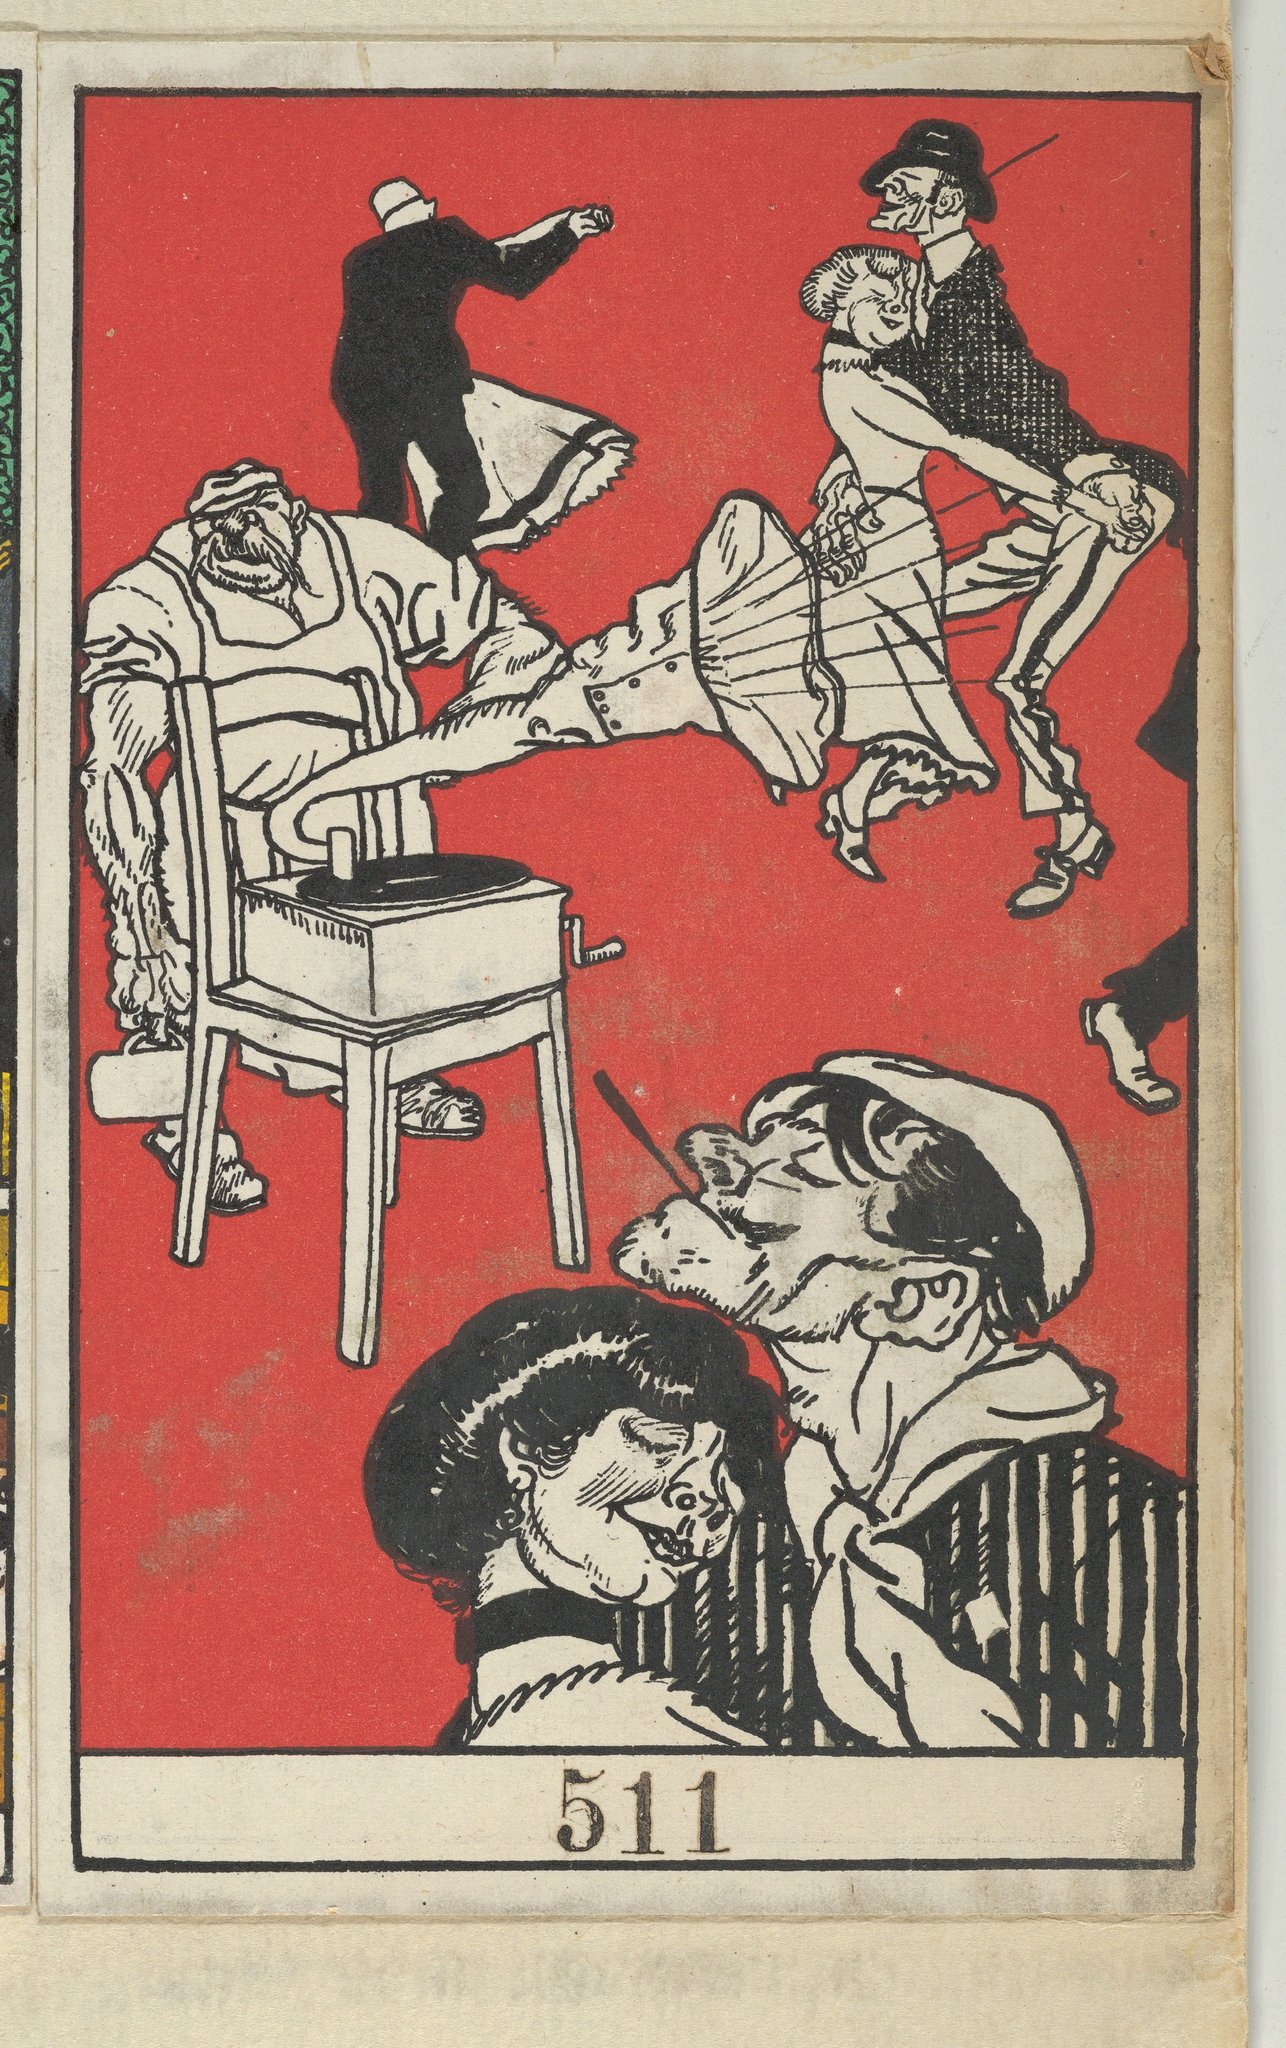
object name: print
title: Dancers (Apachentänze!)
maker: moriz jung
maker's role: artist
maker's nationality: austrian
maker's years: 1885-1915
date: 1911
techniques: lithograph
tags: musical instruments,satire,men,women,dancers